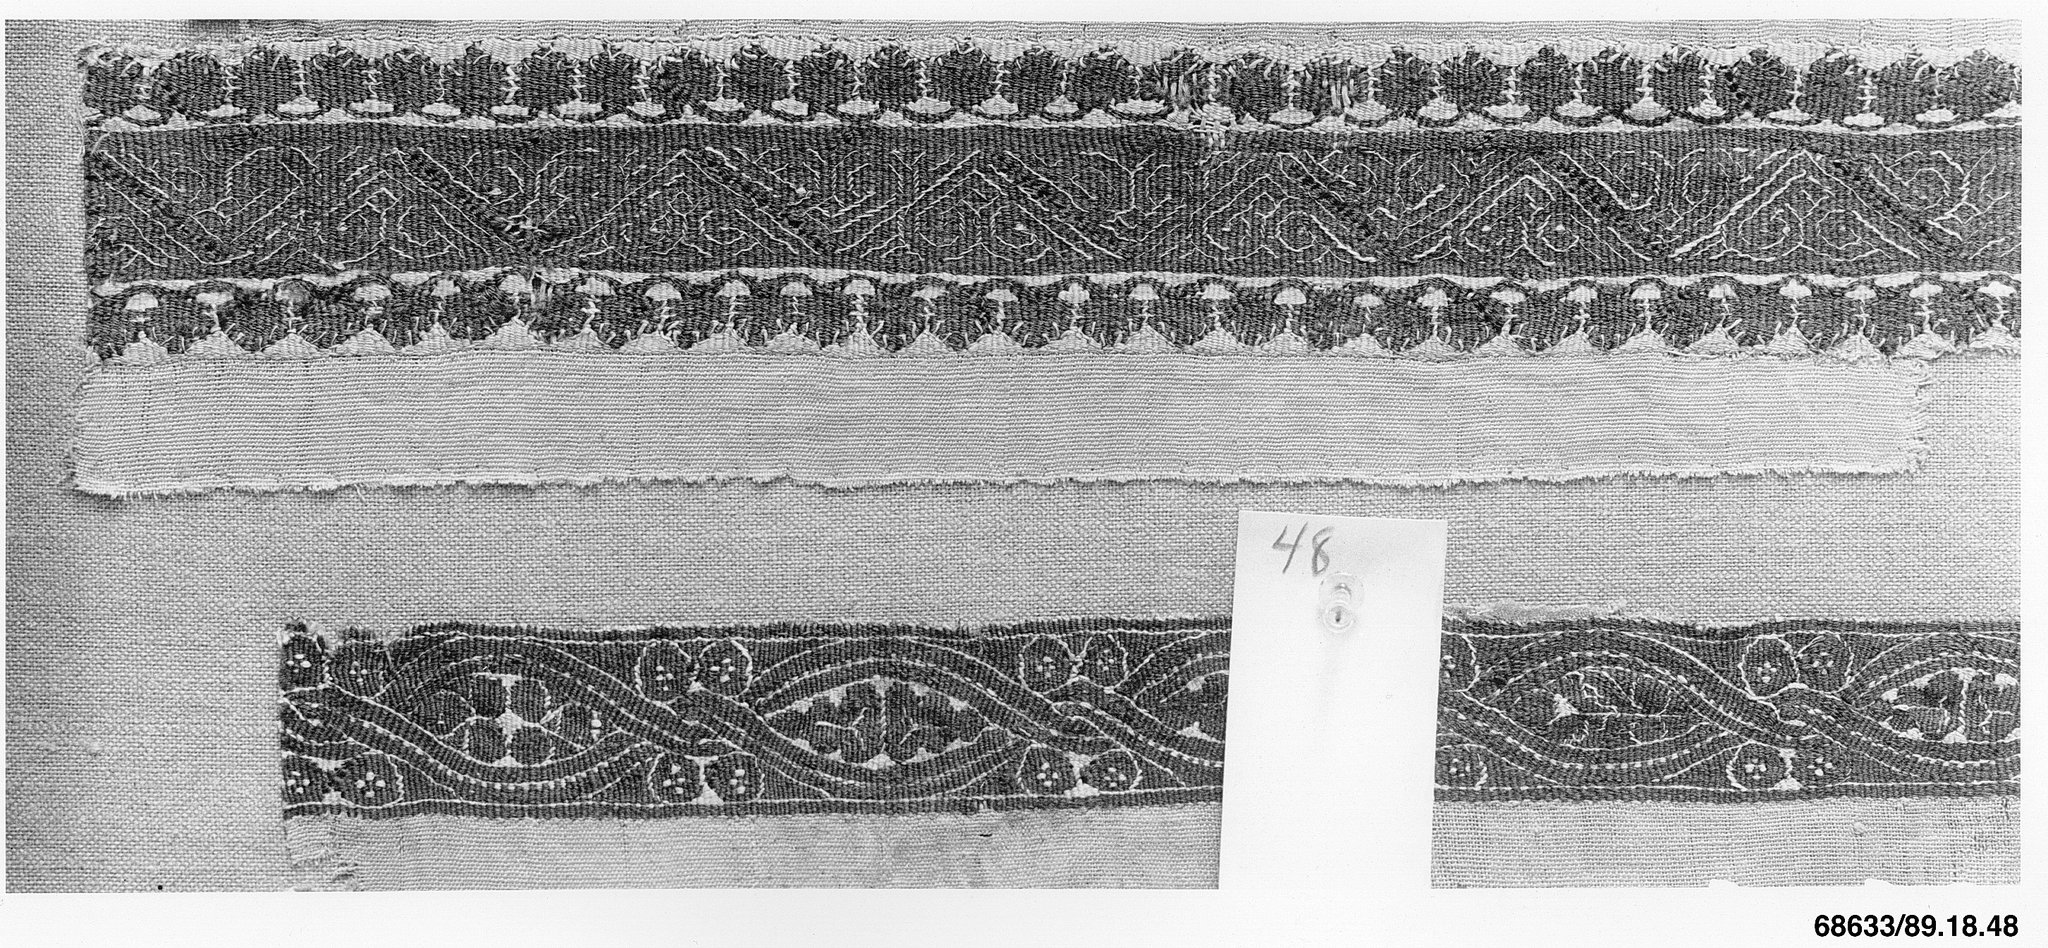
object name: textile fragment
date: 201-400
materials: linen, wool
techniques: weave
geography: egypt